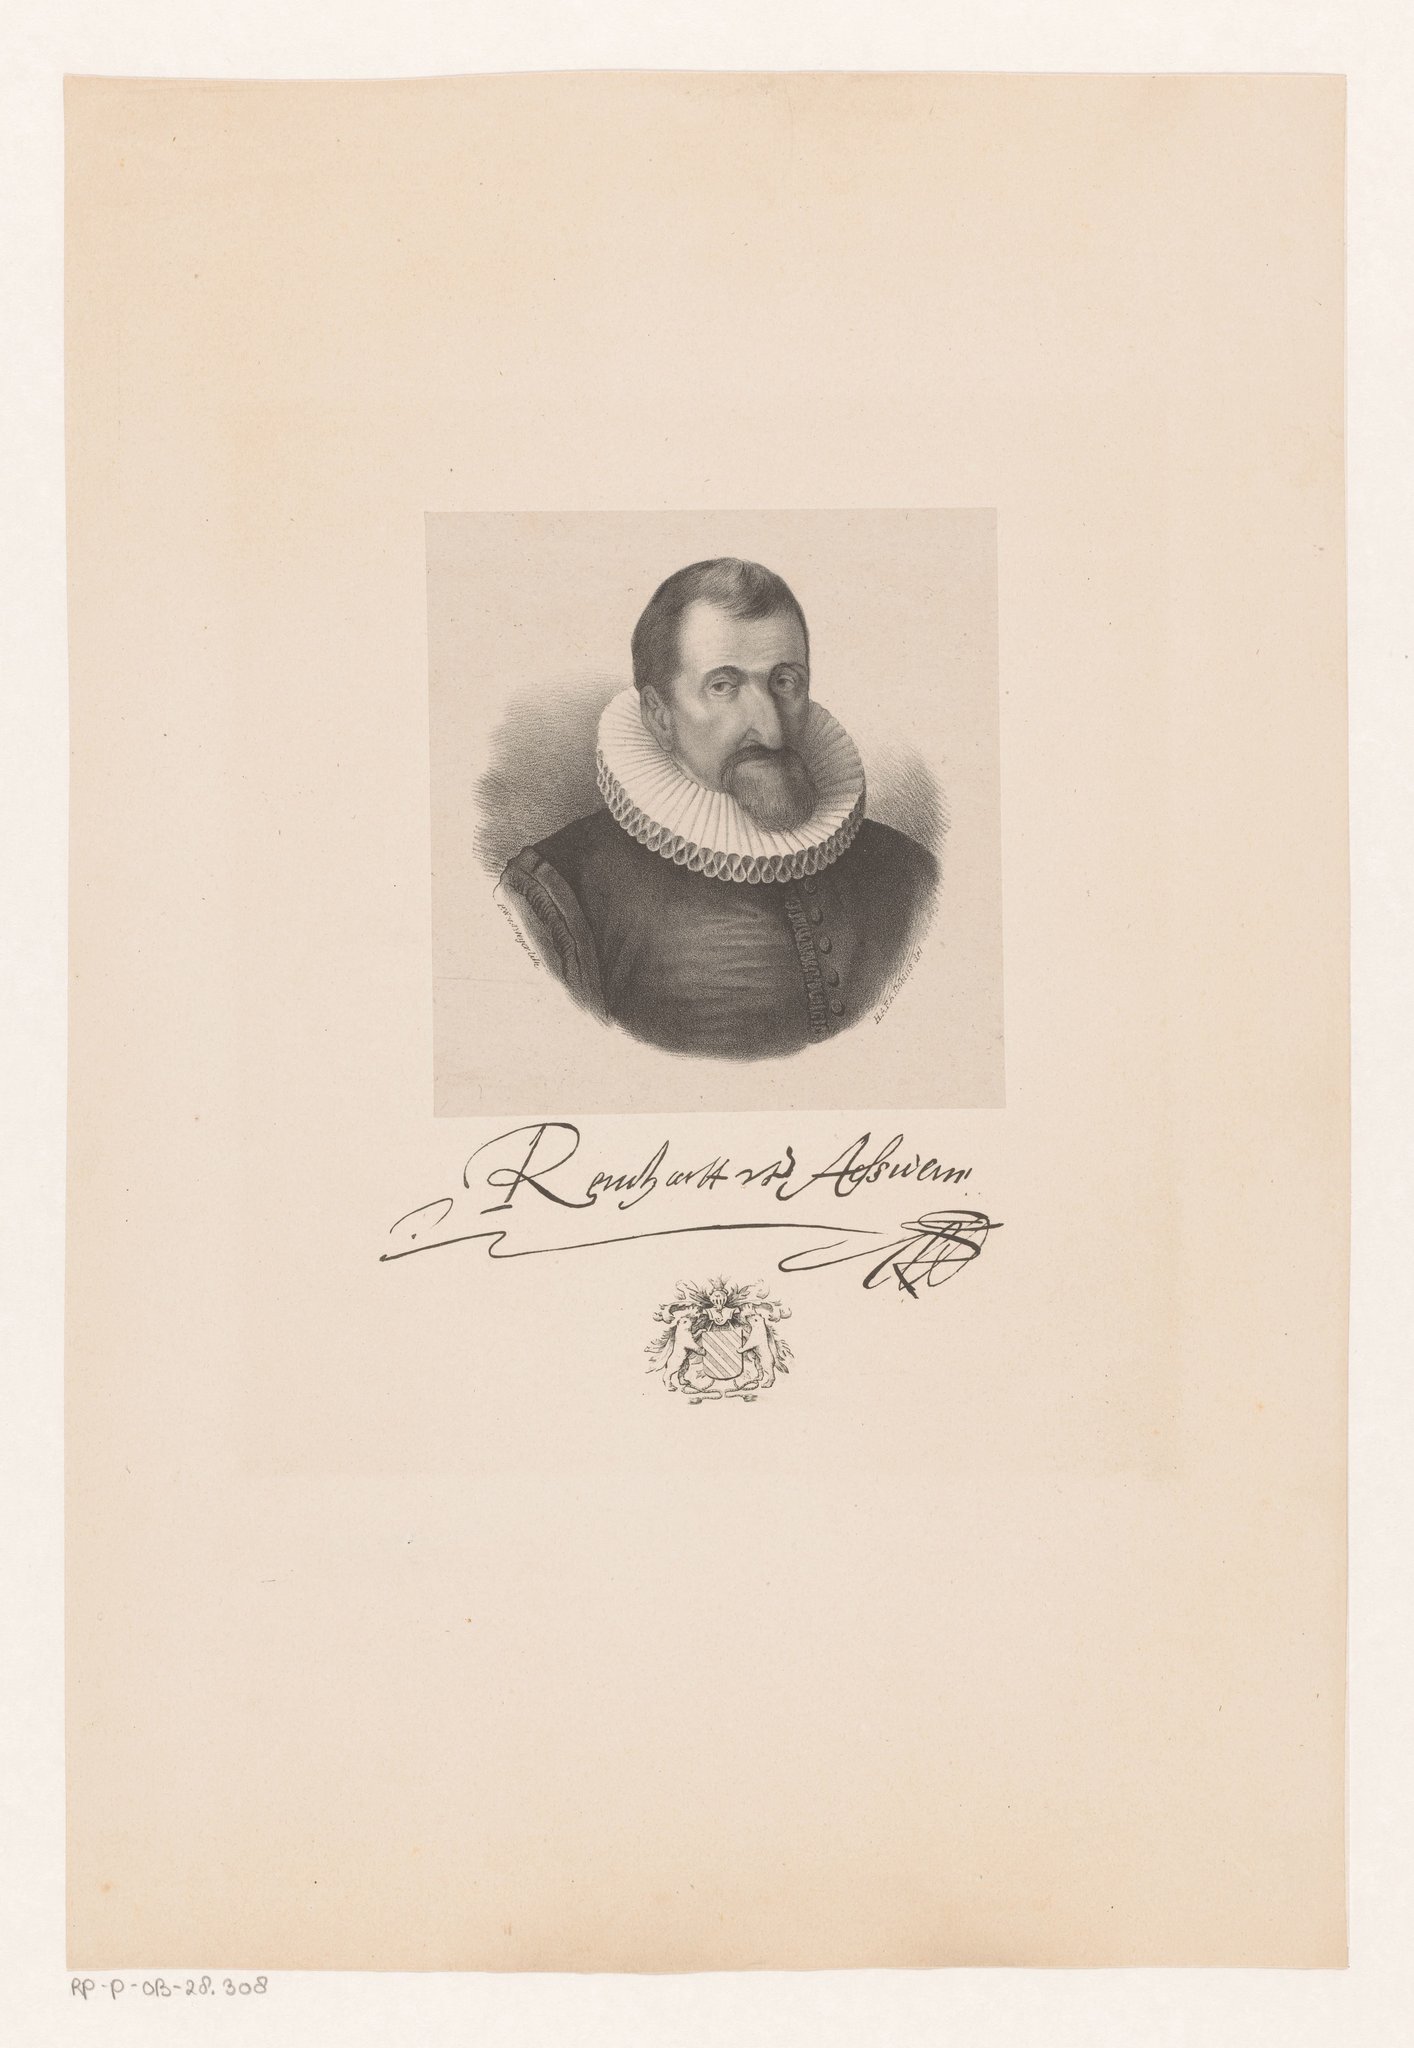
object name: print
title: Portret van Reinier van Aeswijn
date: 1825-1899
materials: paper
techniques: lithograph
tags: historical persons (+ head (and shoulders) (portrait)), neck-gear ~ clothing (with name), armorial bearing, heraldry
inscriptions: collector's mark: Lugt 2228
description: De geportretteerde draagt een plooikraag. Onder het portret zijn signatuur en een familiewapen.